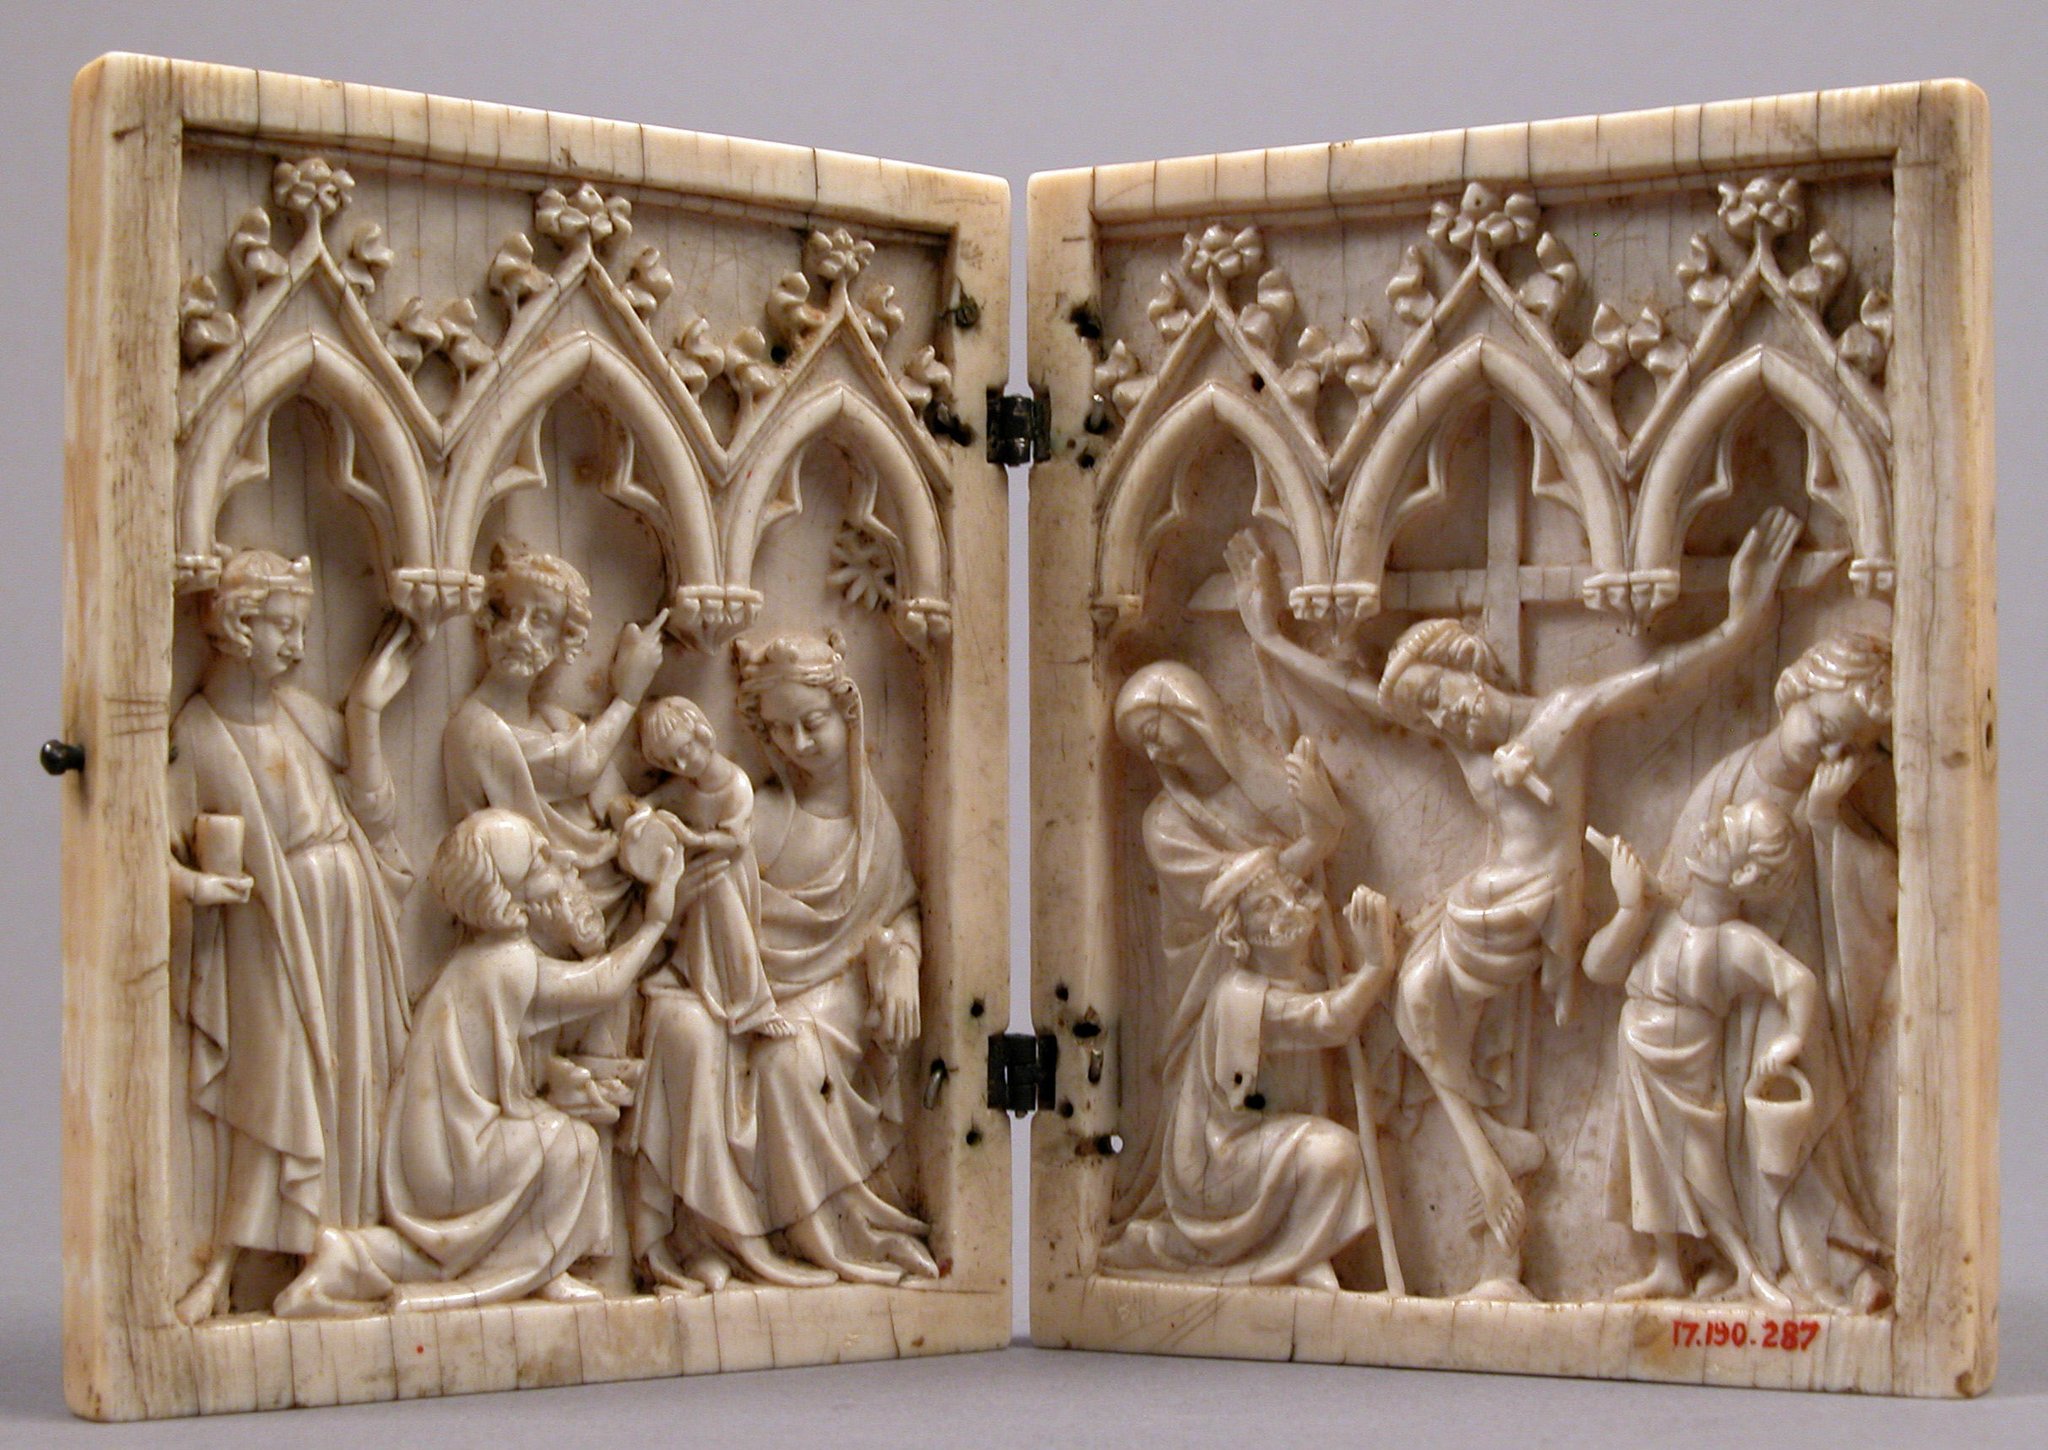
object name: diptych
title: Diptych with the Adoration of the Magi and the Crucifixion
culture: french or german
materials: ivory, metal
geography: france or germany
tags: christ,adoration of the magi,crucifixion